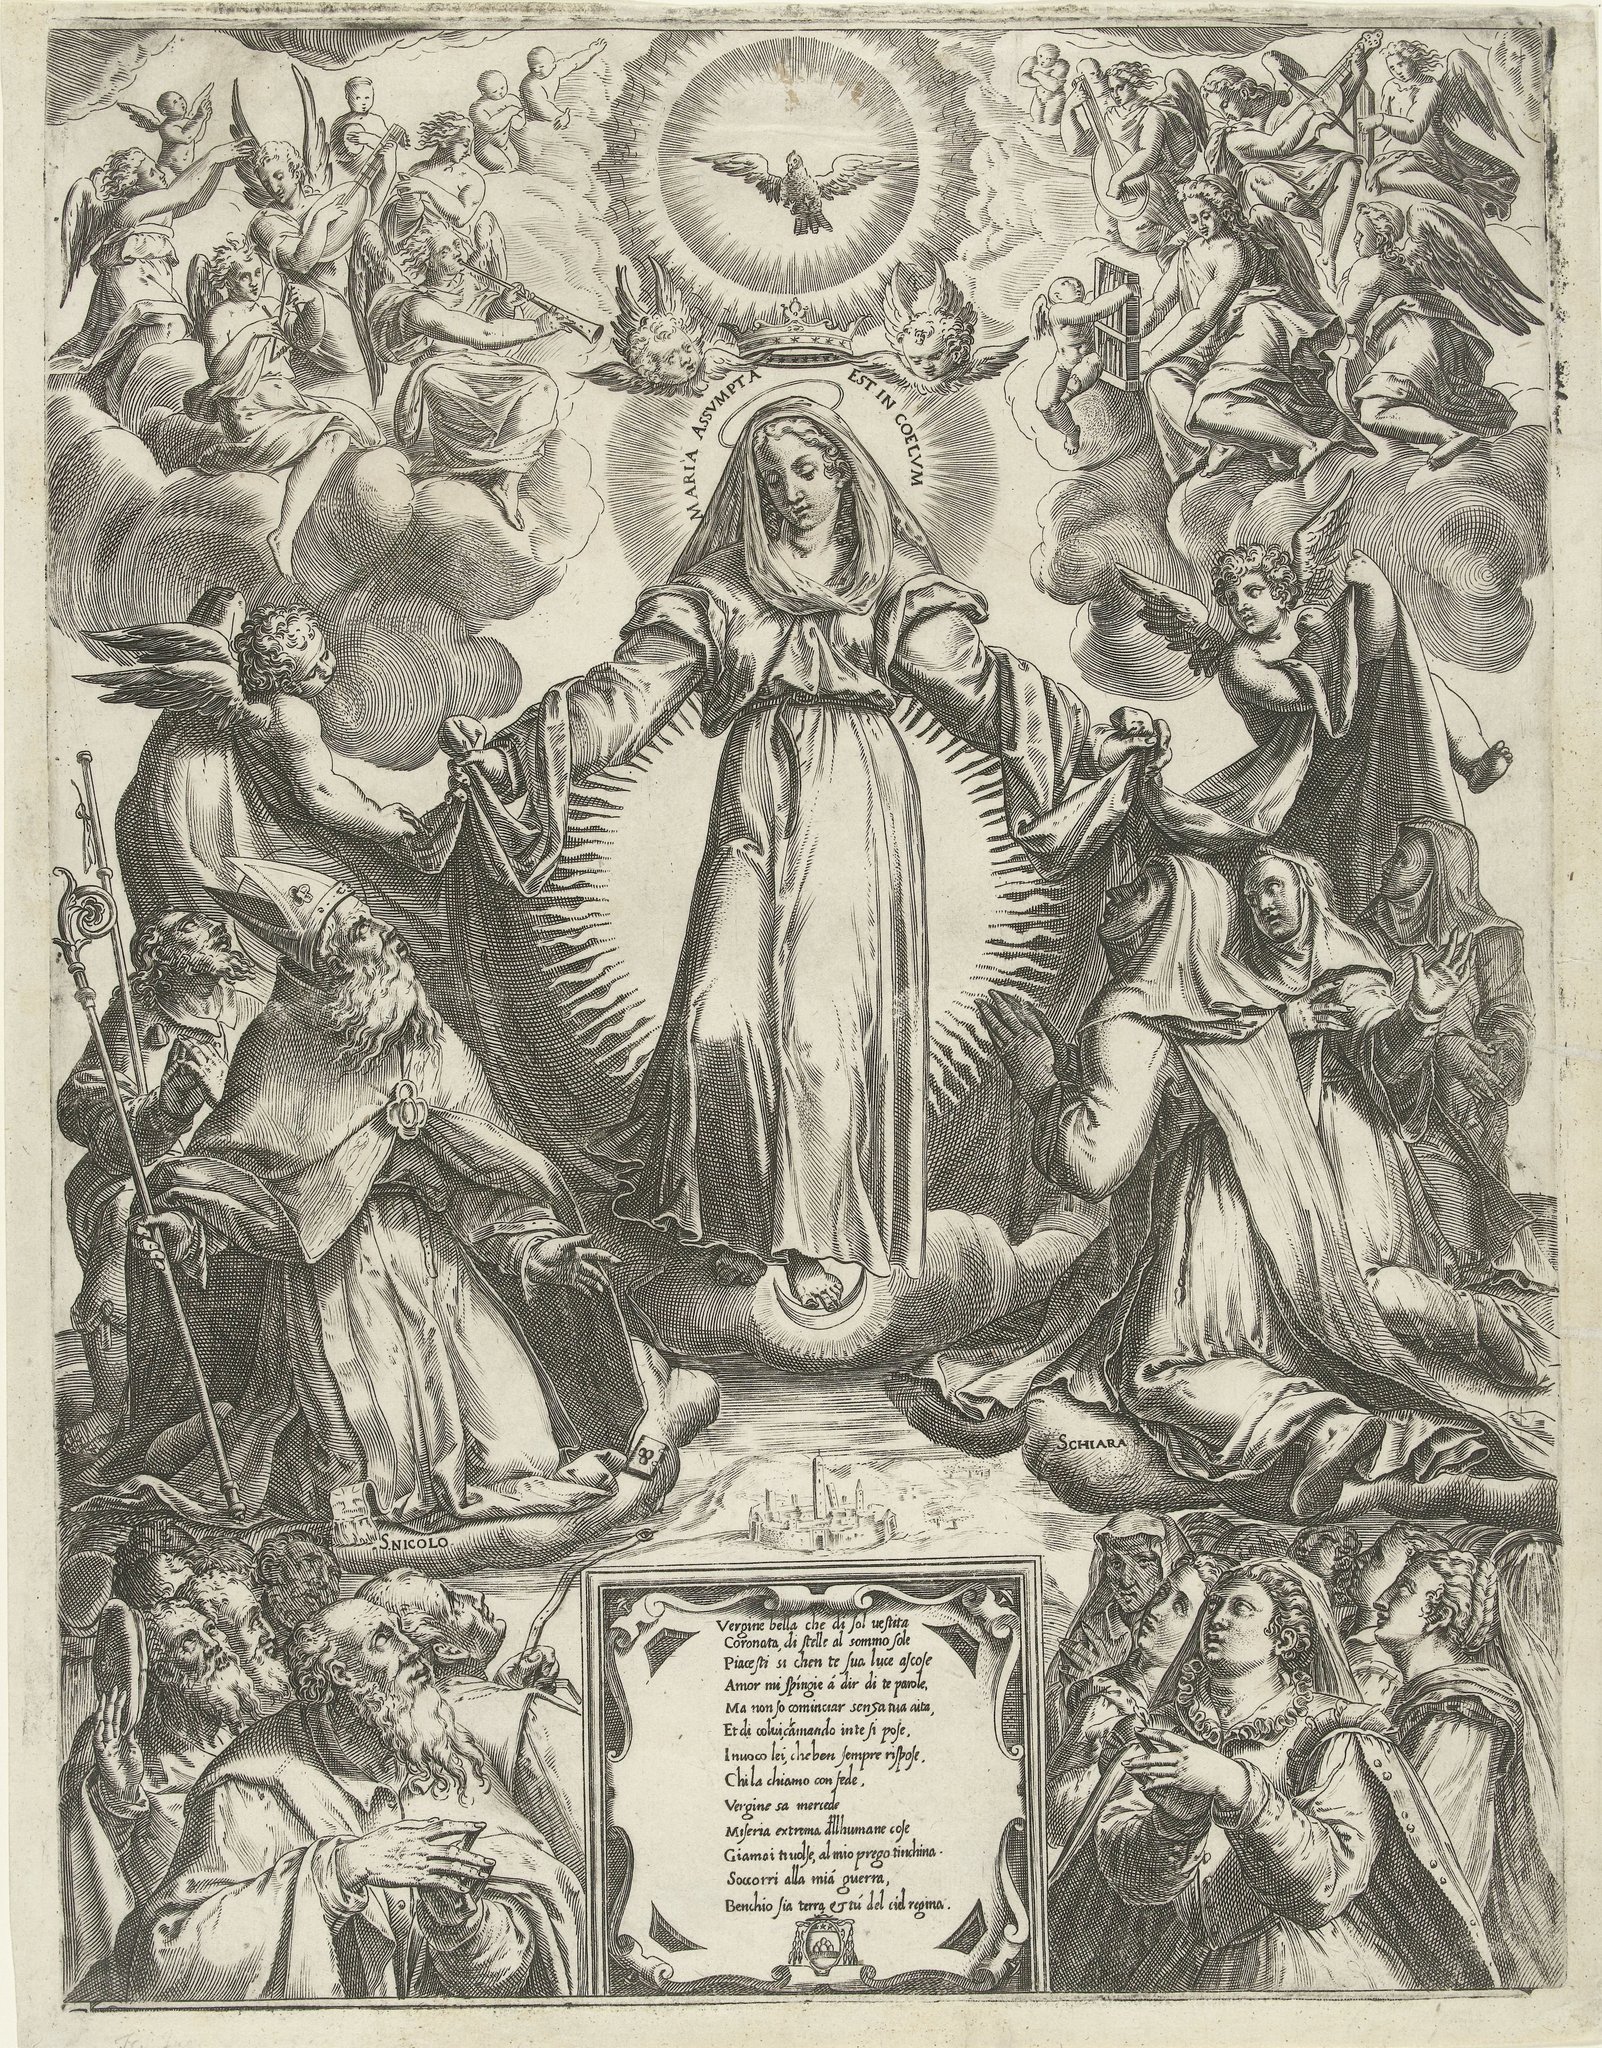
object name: print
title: Hemelvaart en kroning van Maria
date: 1565-1600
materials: paper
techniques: engraving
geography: italy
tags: the assumption of mary ('assumptio corporis'): she is borne into heaven by angels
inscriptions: poem: ‘Vergine bella che di sol vestita/Coronata di stelle al sommo sole/Piace....’, collector's mark: Lugt 2228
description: Maria staat op een kleine maansikkel op een wolk, in een krans van vuur. Links knielt de heilige Nicolaas, rechts de heilige Clara. Linksonder naar Maria opkijkende mannen, rechts vrouwen. In de lucht musicerende engelen met in het midden, boven het hoofd van Maria, de Heilige Geest in de gedaante van een duif. Italiaanse tekst en een wapenschild in een cartouche midden onder.